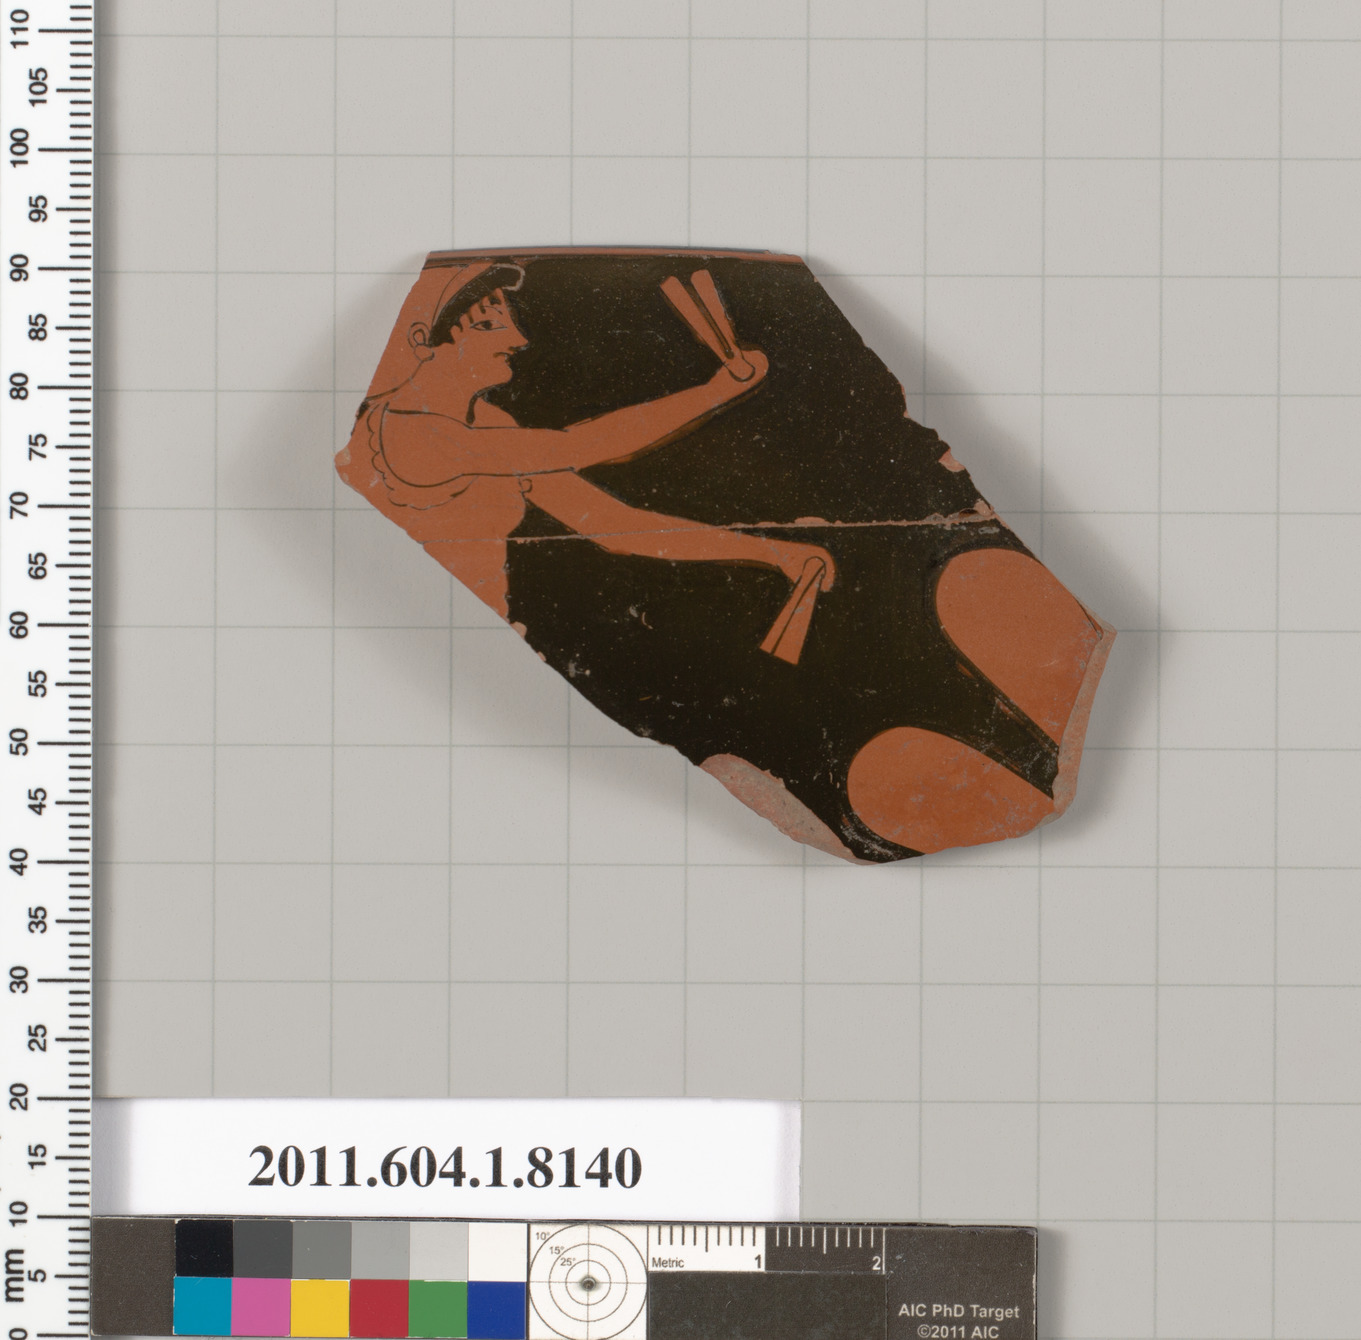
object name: kylix fragment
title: Terracotta rim fragment of a kylix (drinking cup)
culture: greek, attic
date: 520-510 BCE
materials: terracotta